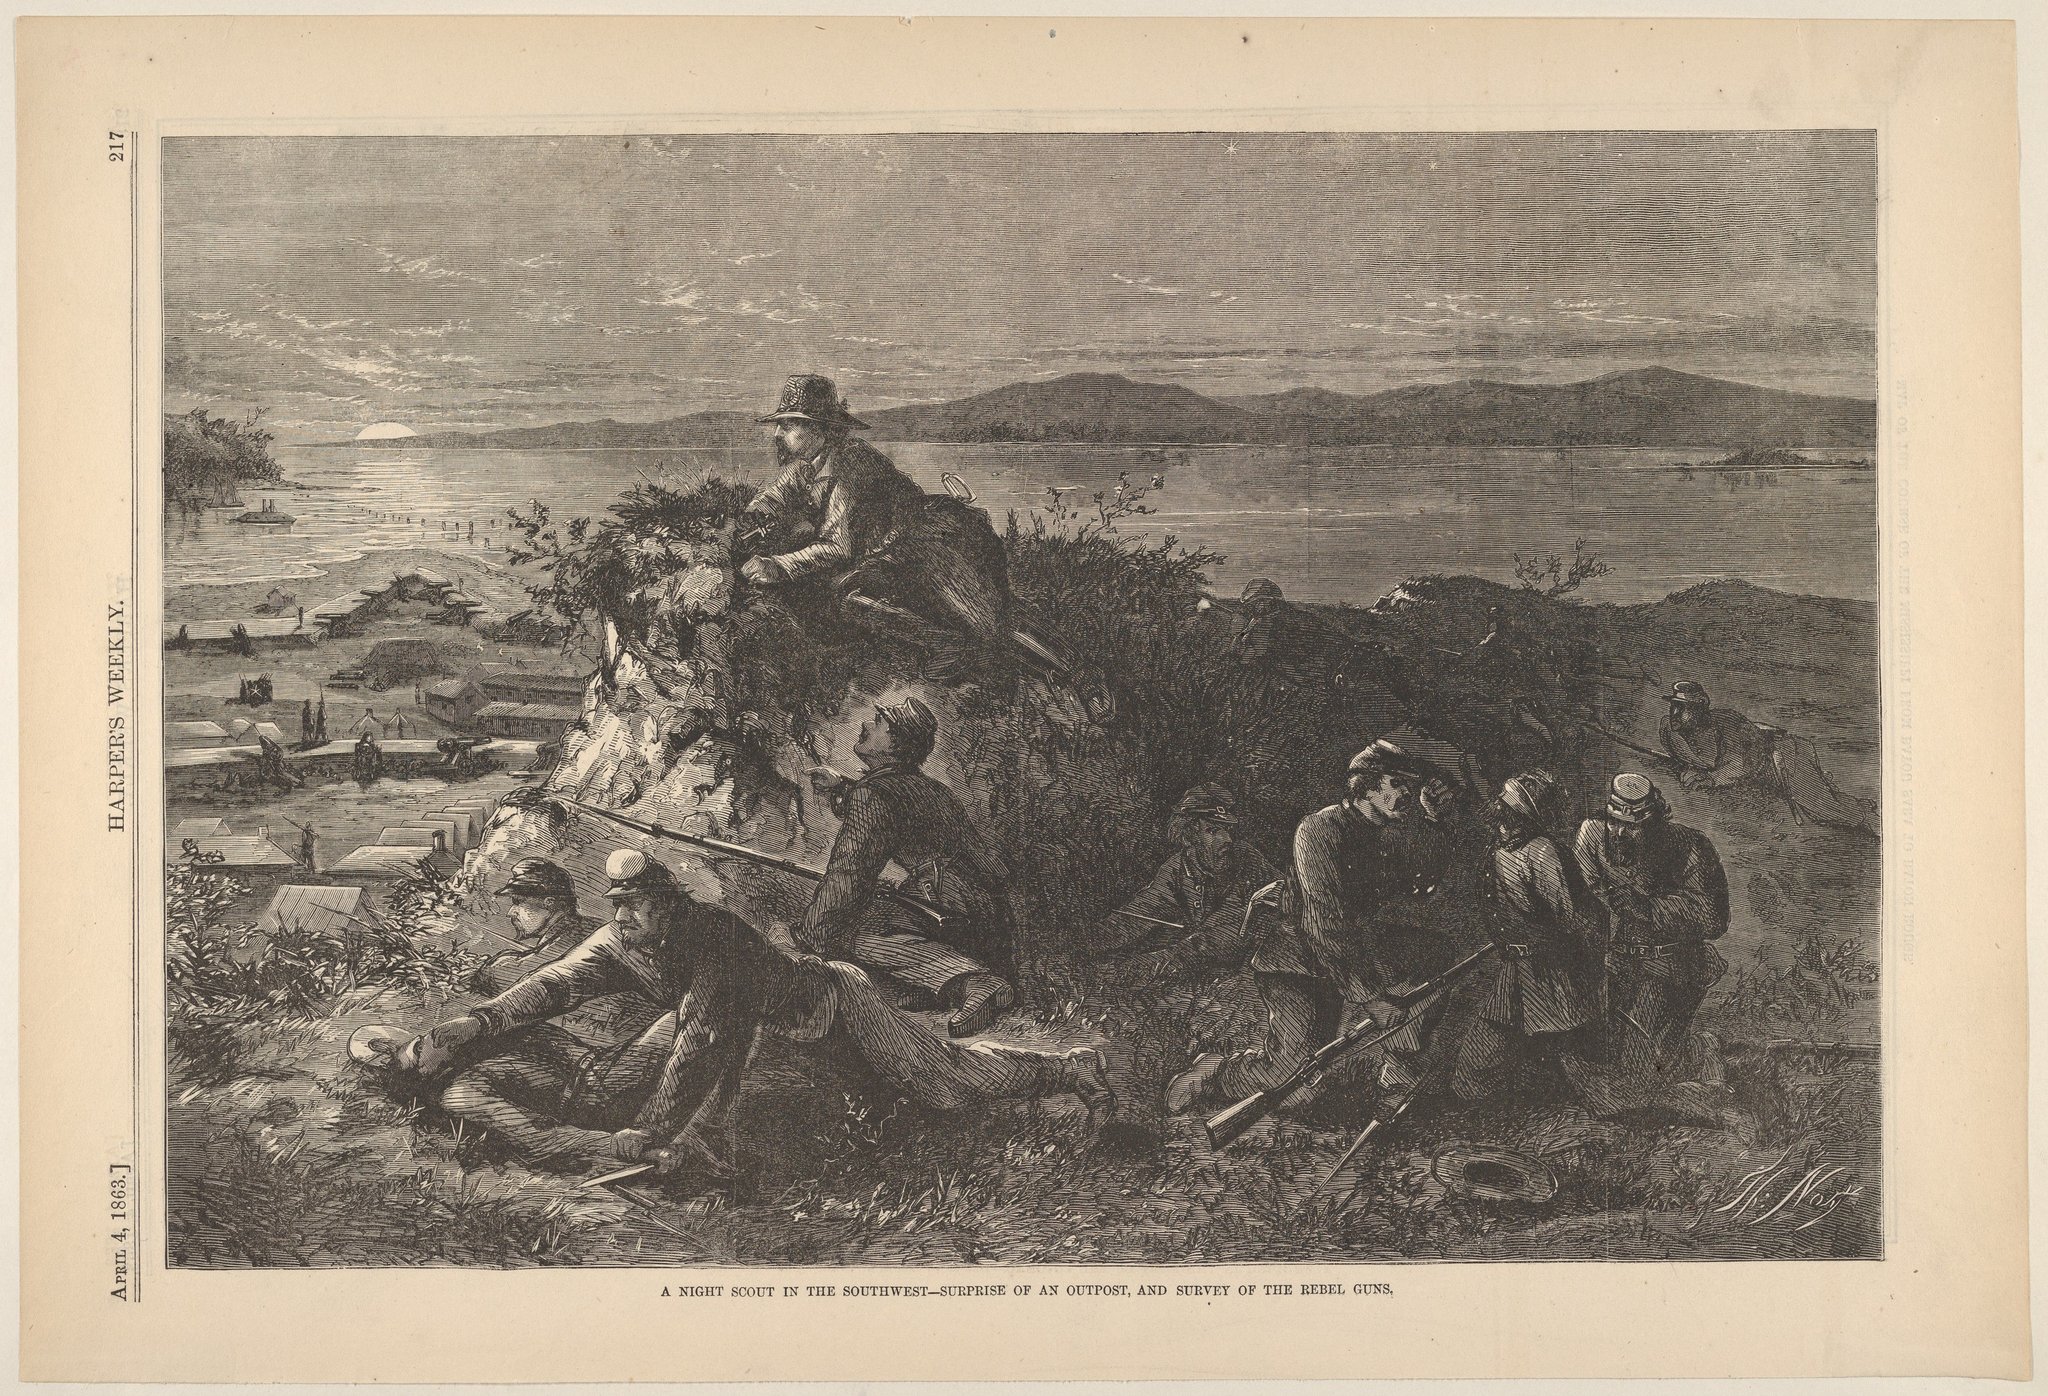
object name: print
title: A Night Scout in the Southwest – Surprise of an Outpost, and Survey of the Rebel Guns (from "Harper's Weekly")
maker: thomas nast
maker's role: artist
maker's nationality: american, born germany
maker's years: 1840-1902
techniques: engraving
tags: soldiers,american civil war